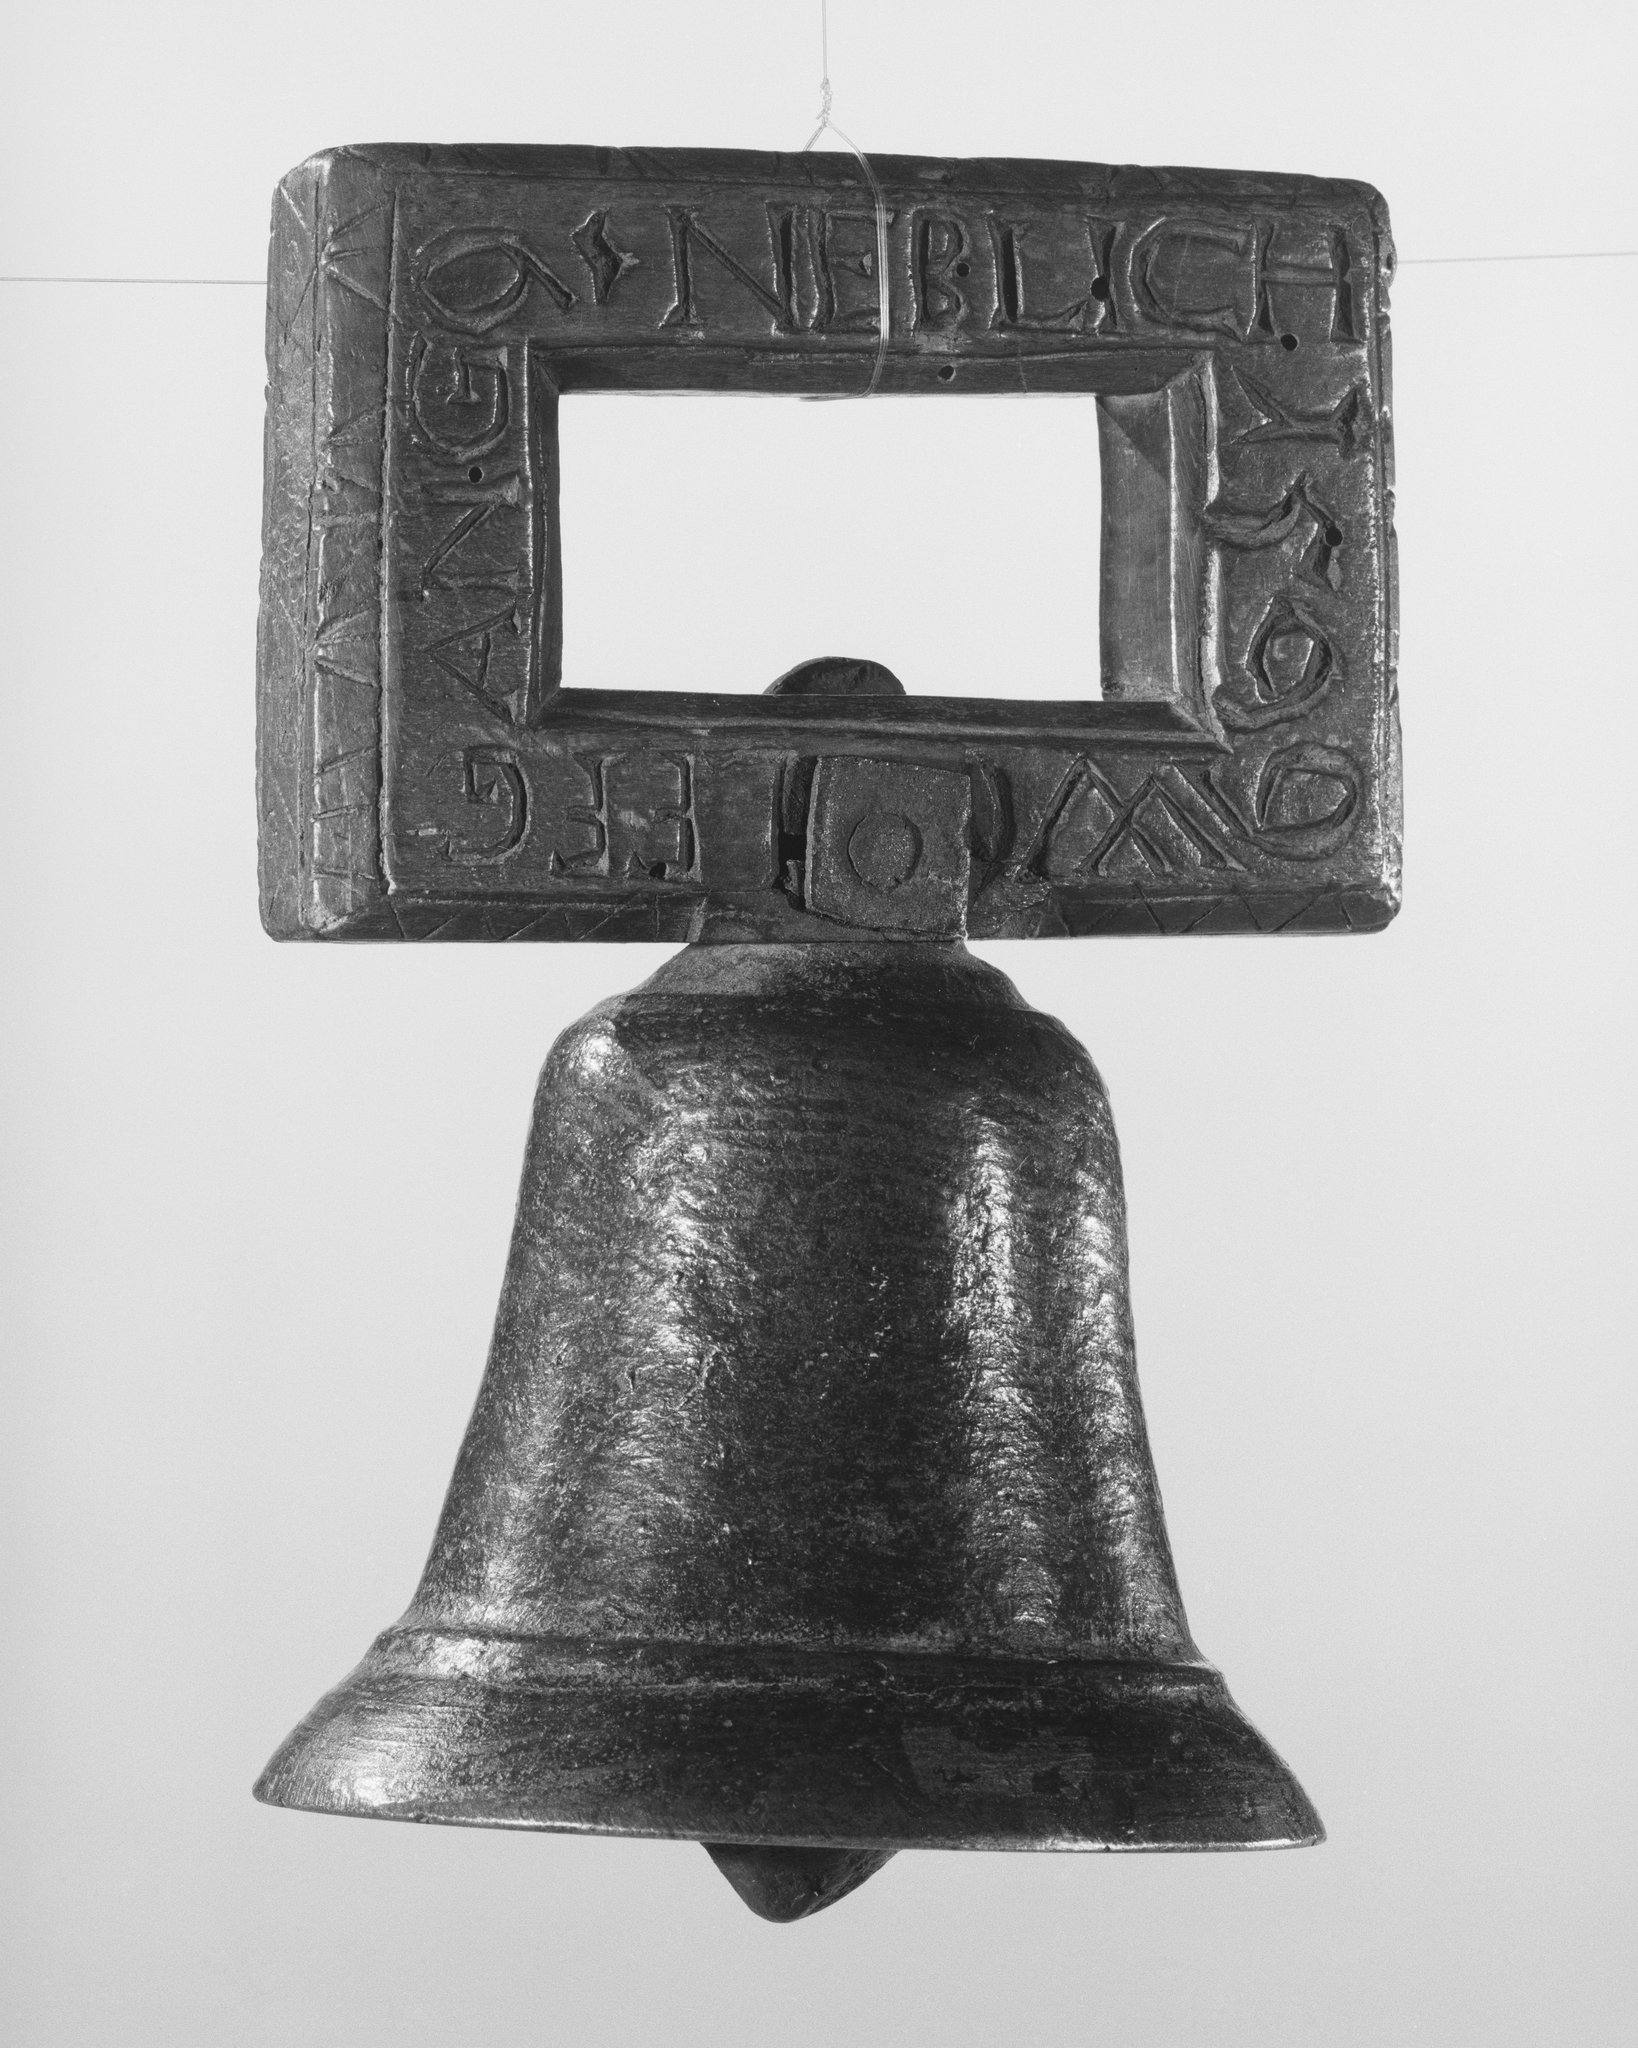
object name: bell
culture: german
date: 1599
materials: bronze, wood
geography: germany